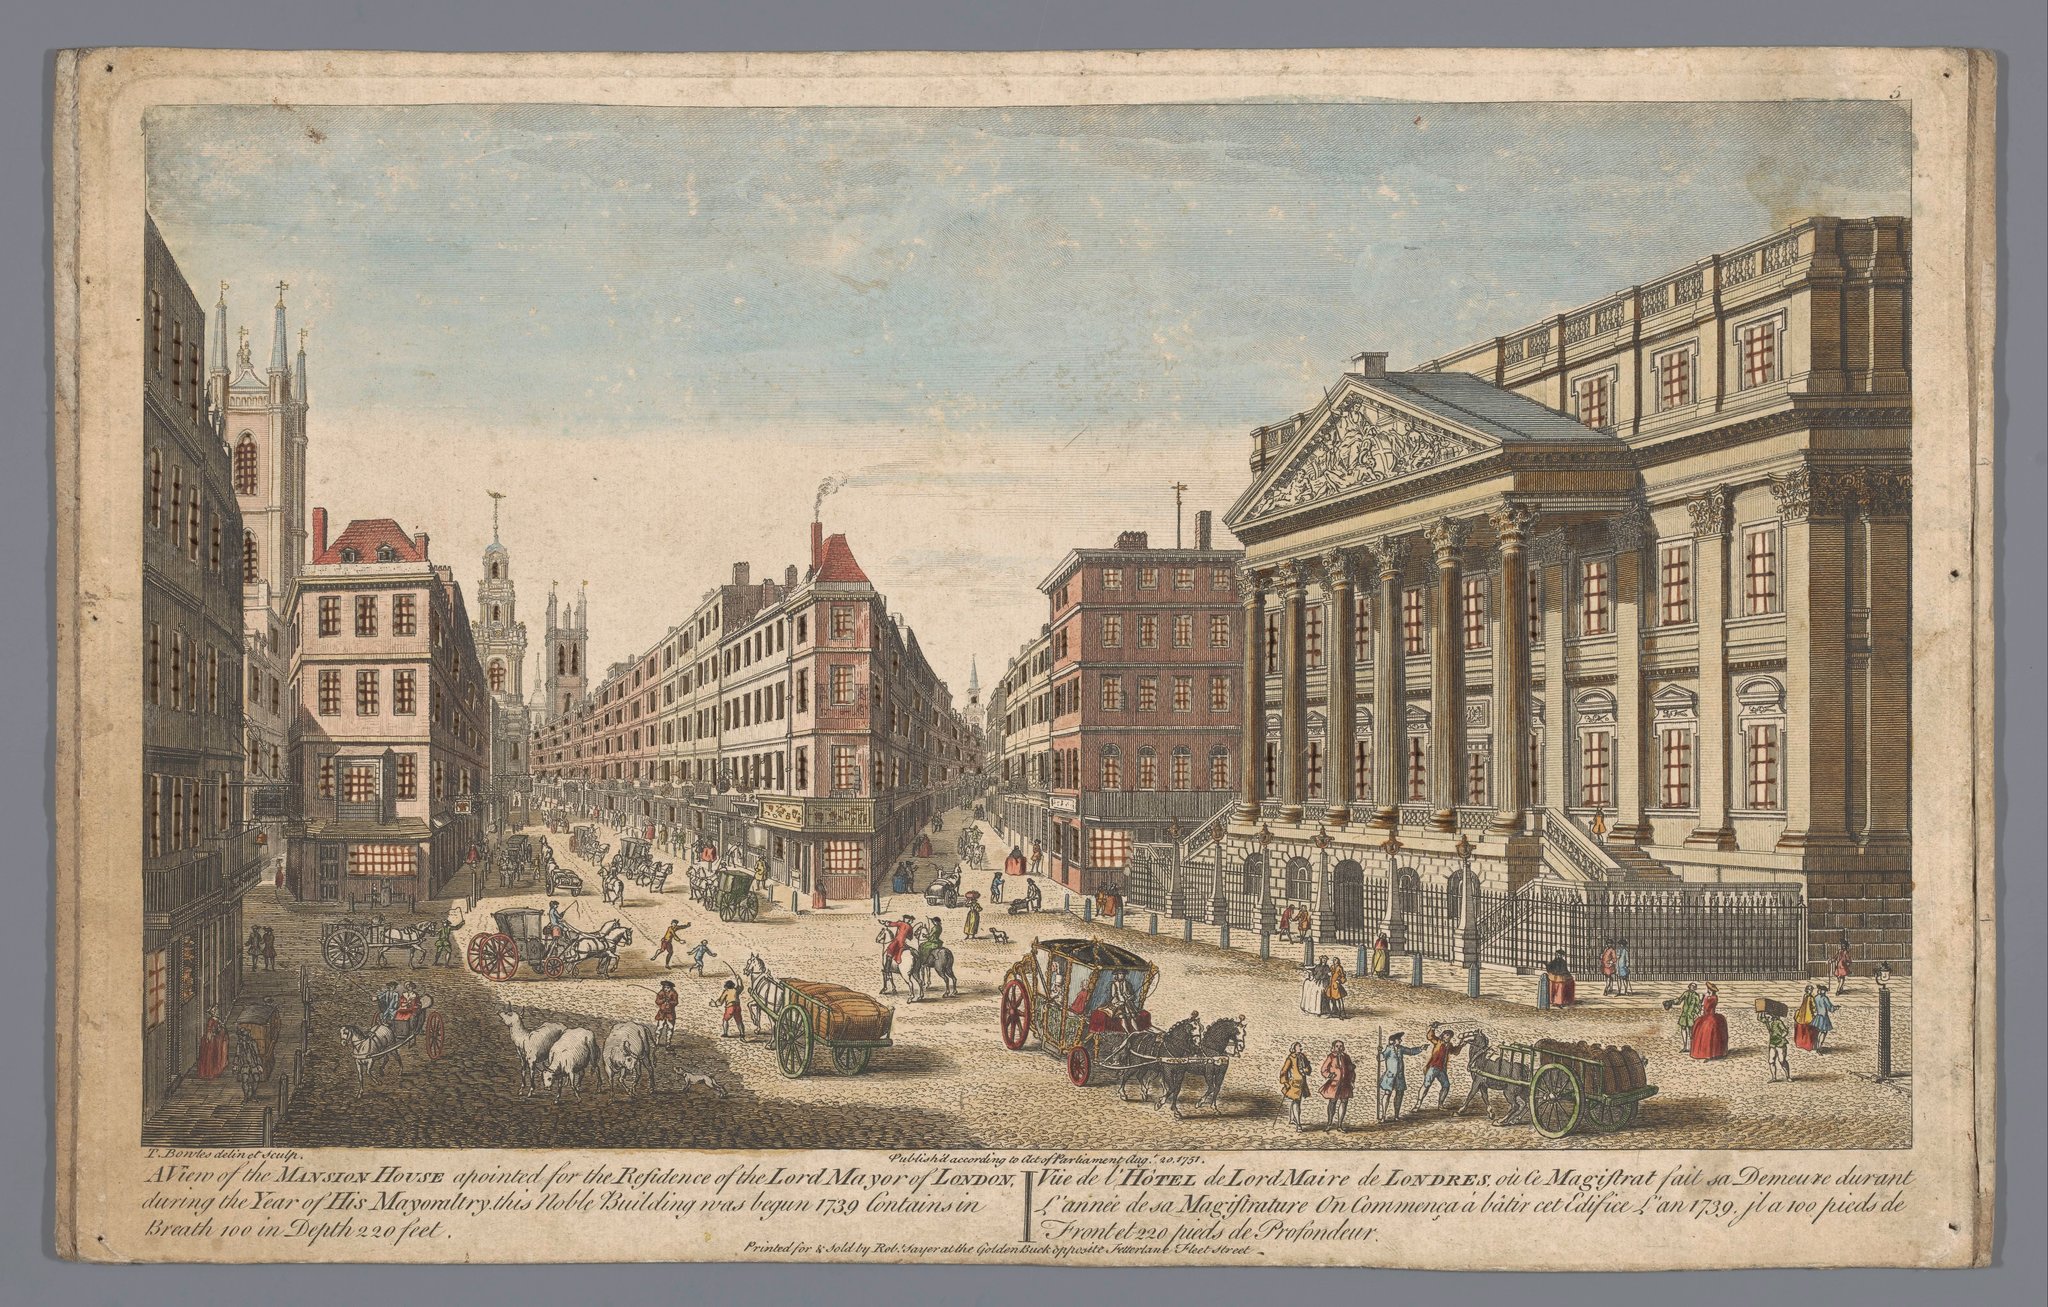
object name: print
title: Londen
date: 1751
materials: cardboard, paper, watercolor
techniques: brush, etching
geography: london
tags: mayor, burgomaster, civic architecture; edifices; dwellings, street (+ city(-scape) with figures, staffage)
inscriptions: collector's mark: Lugt 2233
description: De serie “Londen” bevat 52 prenten met de nummers 1-52, waarvan dit nummer 8 is.